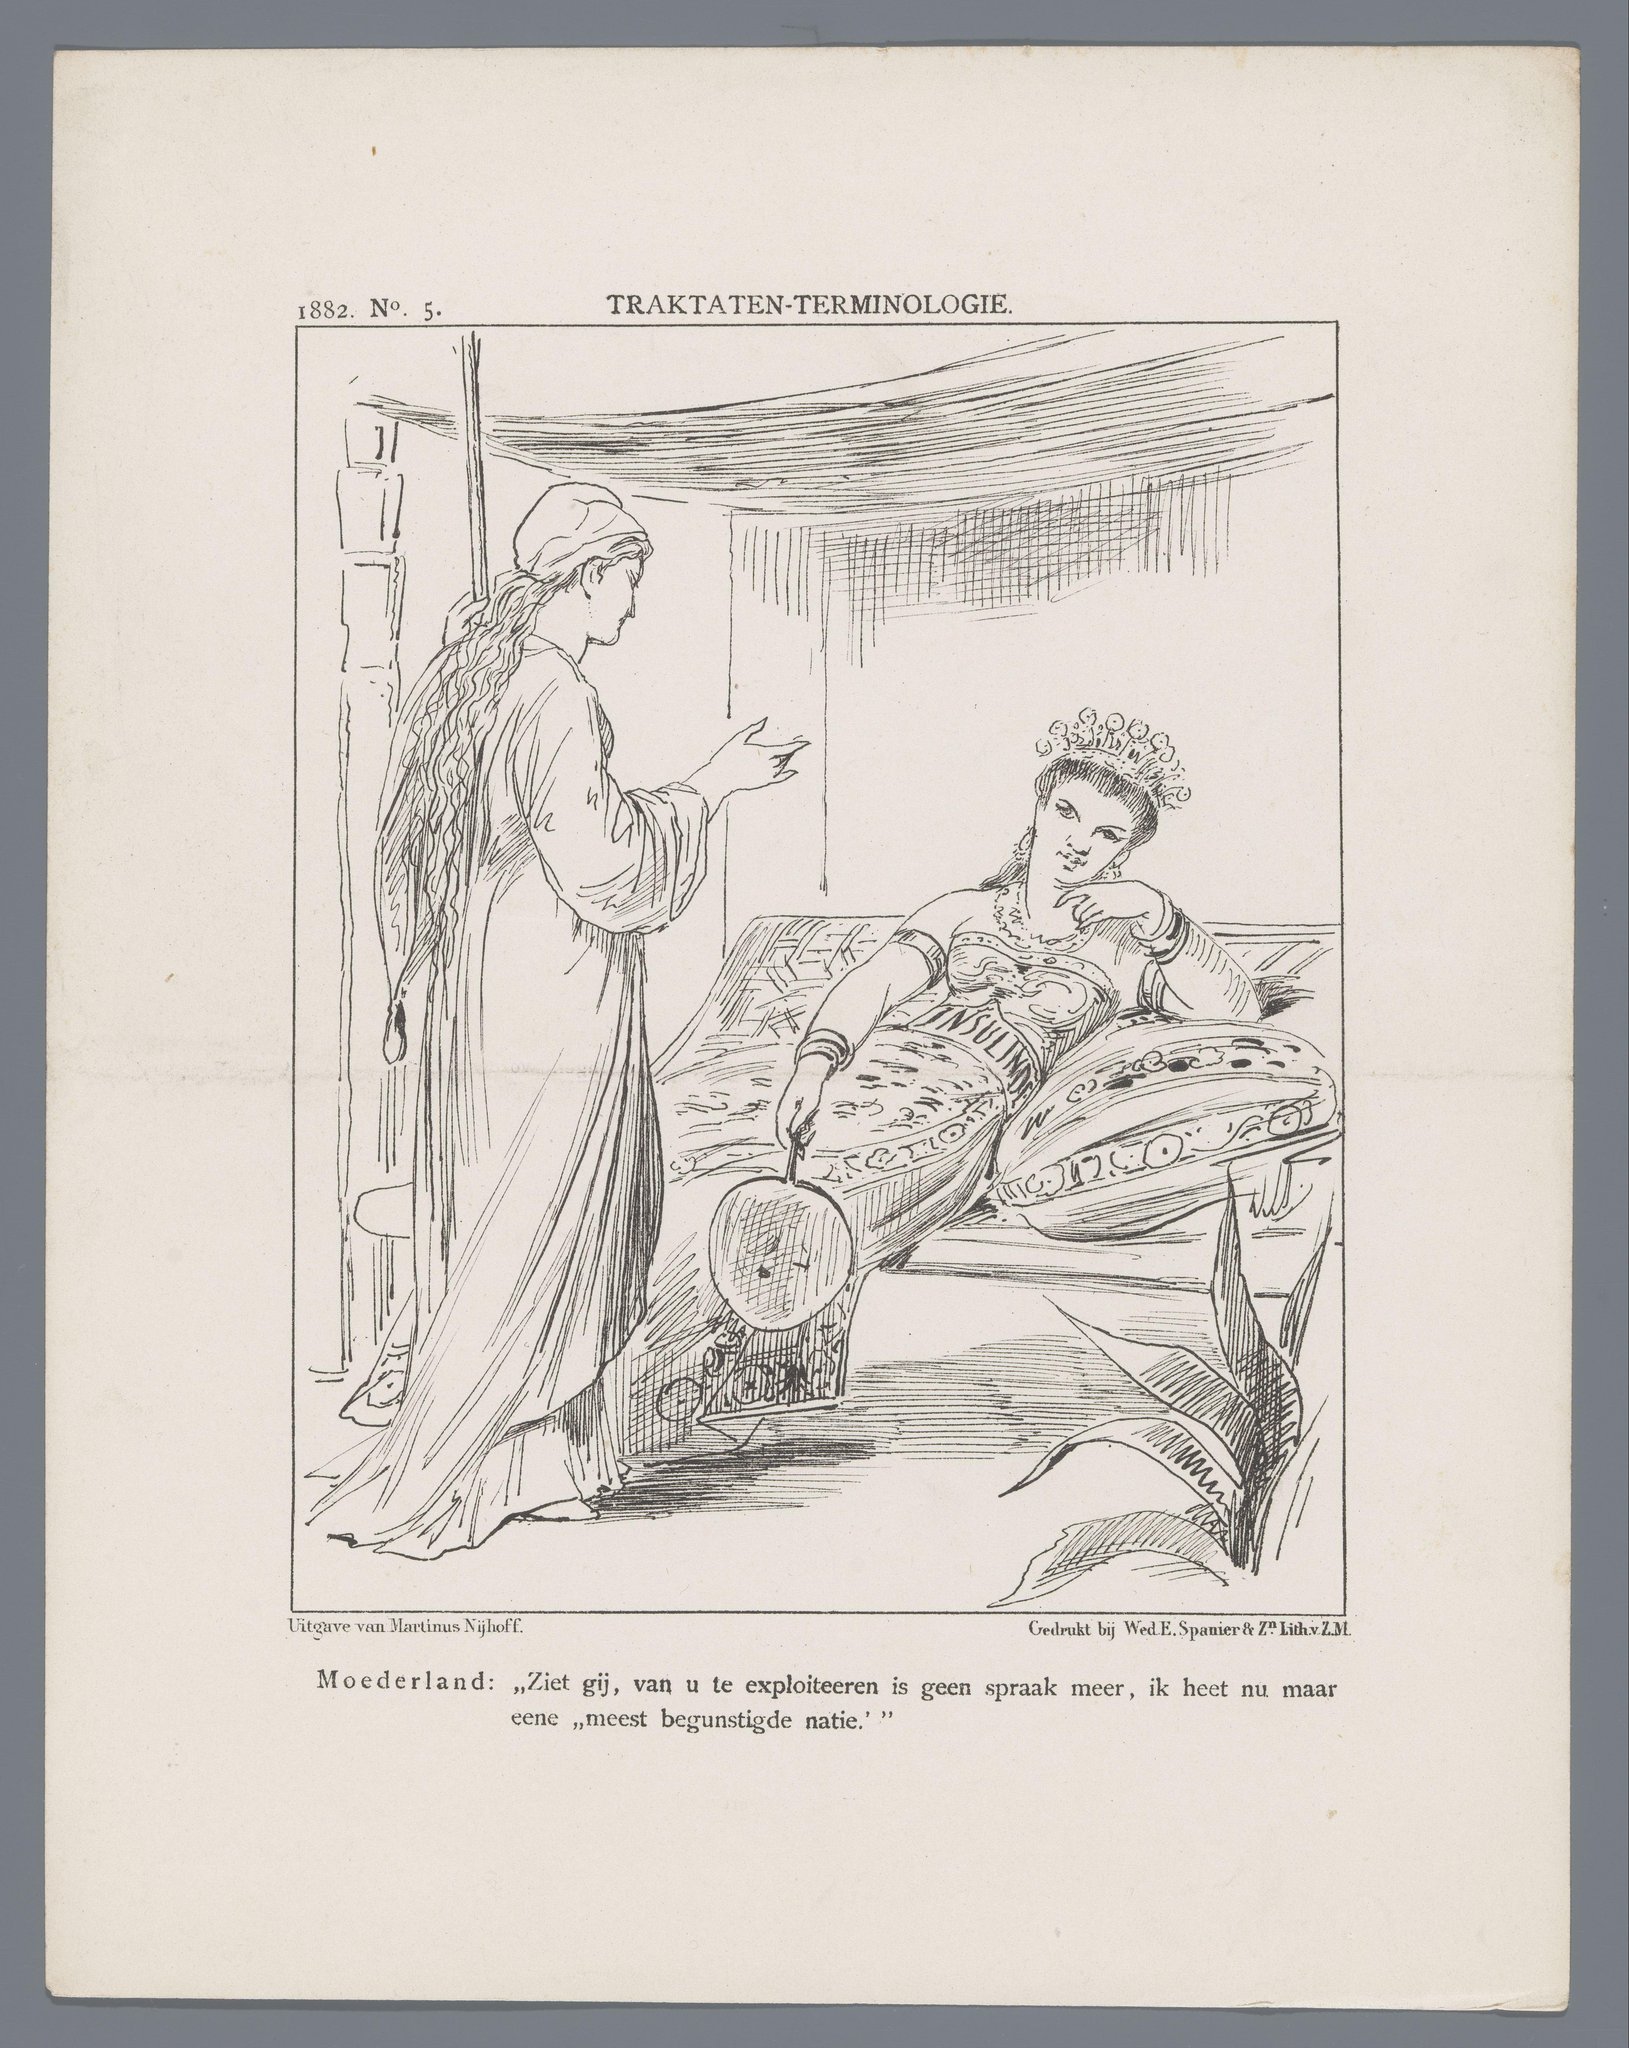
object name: cartoon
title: Politieke spotprent over Nederlands-Indië, 1882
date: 1882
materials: paper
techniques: lithograph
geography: netherlands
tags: dutch east indies, the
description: Politieke spotprent over Nederlands-Indië, 1882. Plaat verschenen bij het weekblad De Nederlandsche Spectator, nr. 5, 1882.